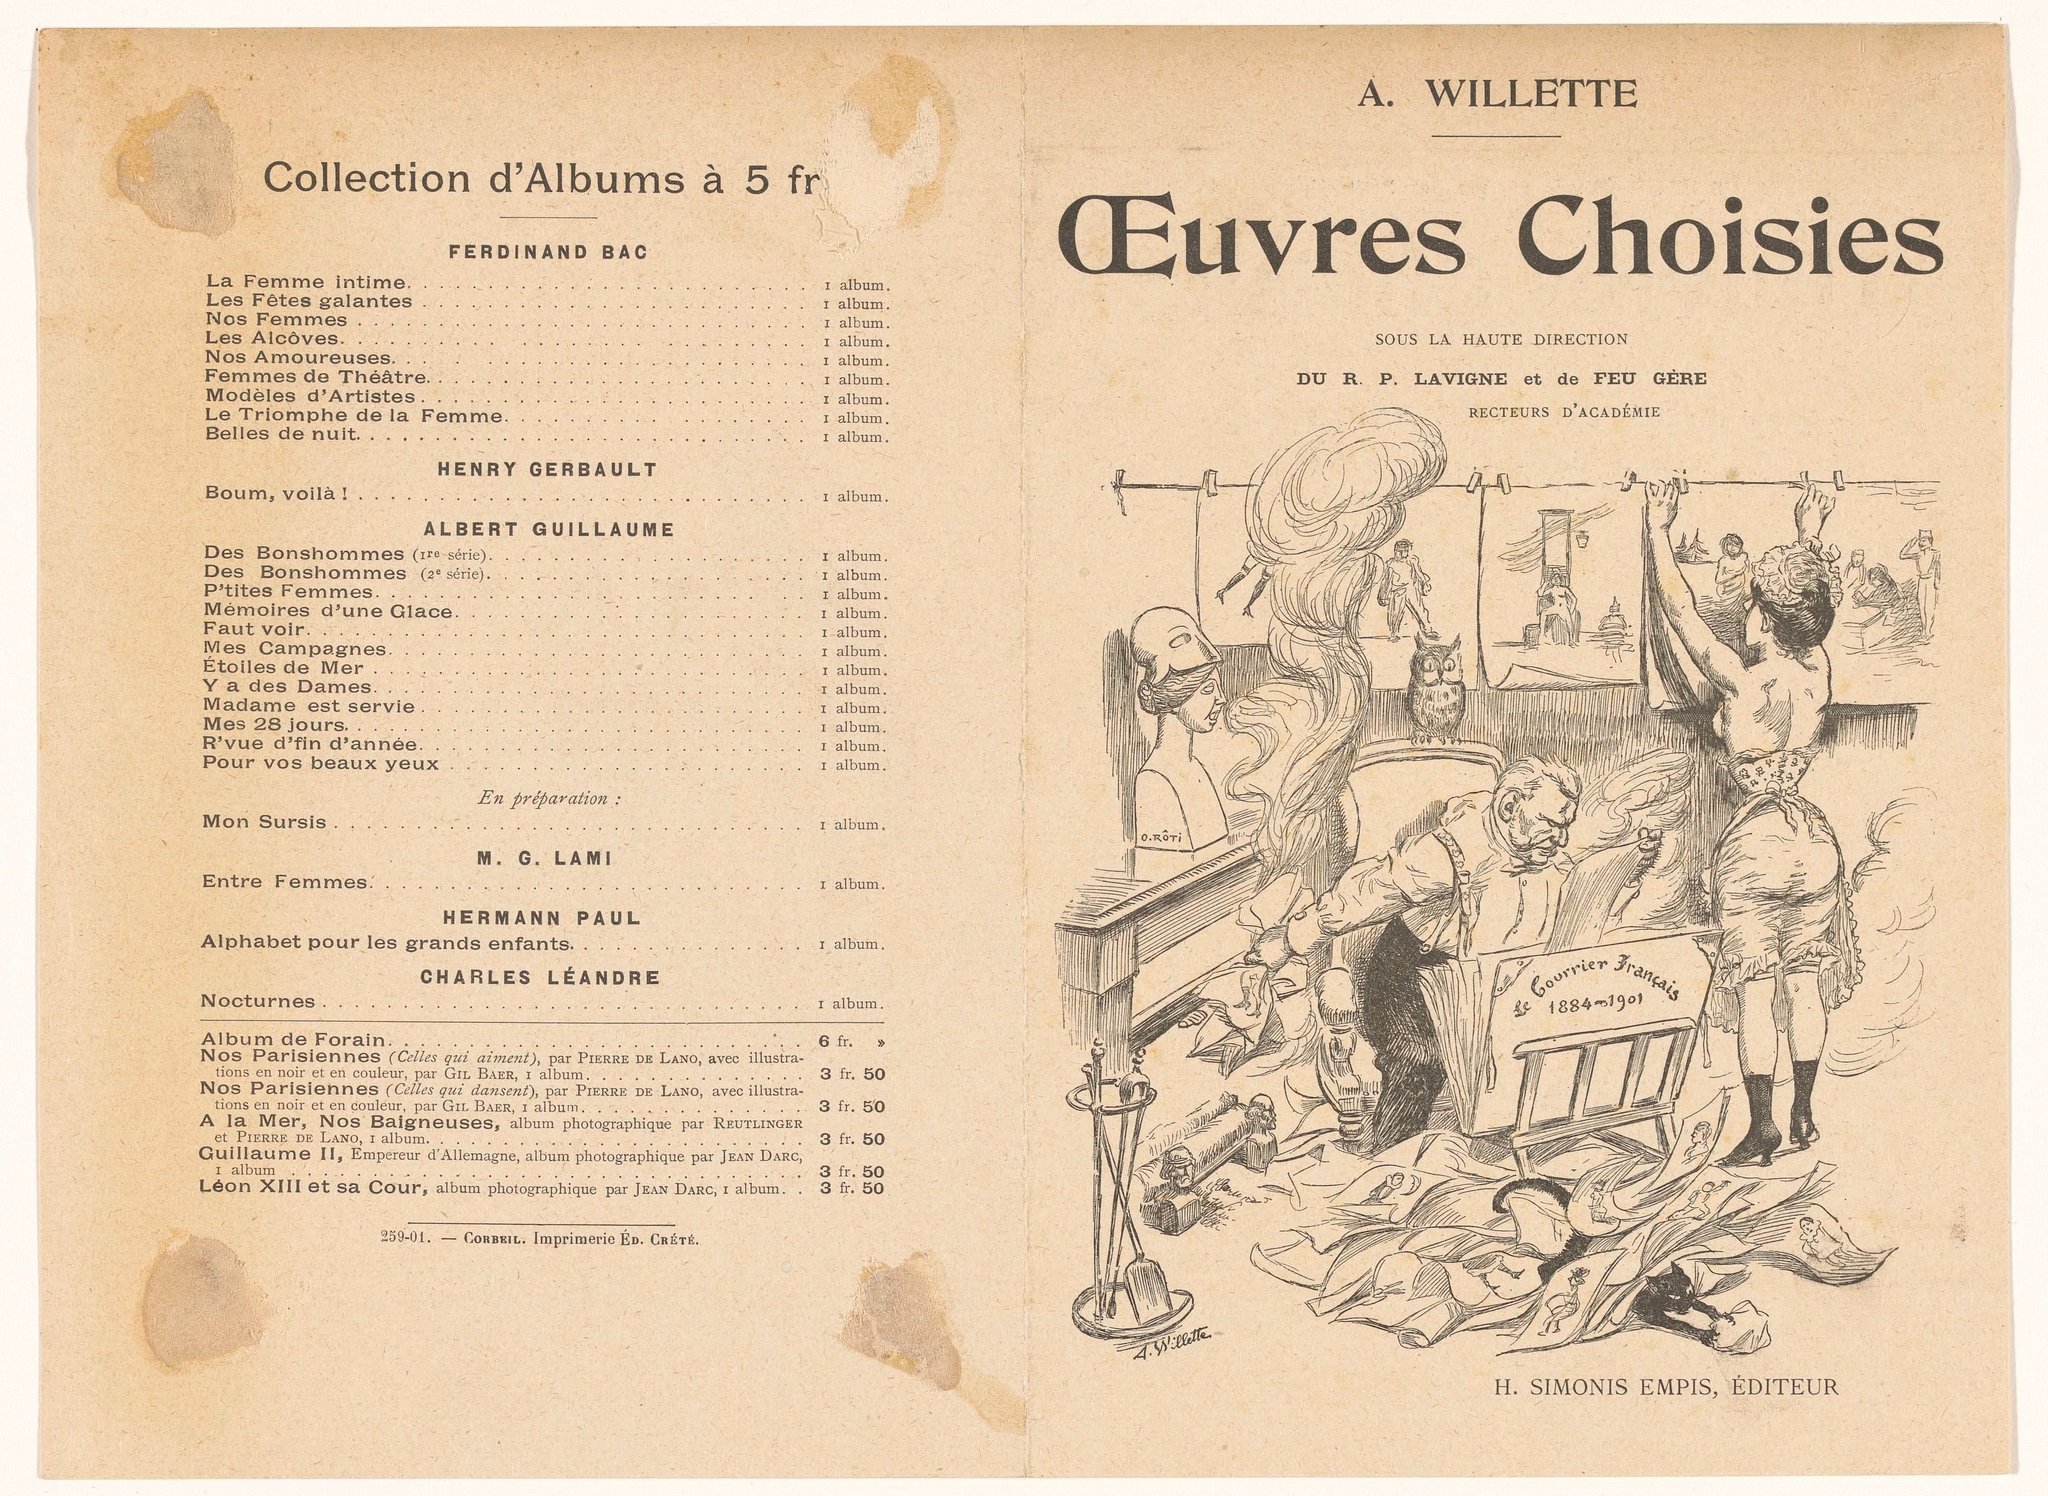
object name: uitgeversprospectus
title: Uitgeversprospectus voor de Oeuvres Choisies van Adolphe Léon Willette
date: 1901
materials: paper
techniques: printing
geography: paris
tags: chimney, damaging or destroying a work of art, art collector (+ graphic arts), woman (showing herself) undressed, quasi-nude, maid ~ house personnel, specific aspects, allegorical aspects of minerva; minerva as patroness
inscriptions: collector's mark: Lugt 2228, collector's mark: Lugt 4779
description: In een stoel zit een man met rood aangelopen hoofd voor een prentstandaard met prenten afkomstig uit 'Le Courrier Français'. Met zijn rechterhand gooit hij enkele prenten in het haardvuur. Naast hem staat een halfnaakte dienstmeid die prenten aan een waslijn hangt. Op de schouw staat een buste van Minerva en op de rugleuning van de stoel zit een uil.